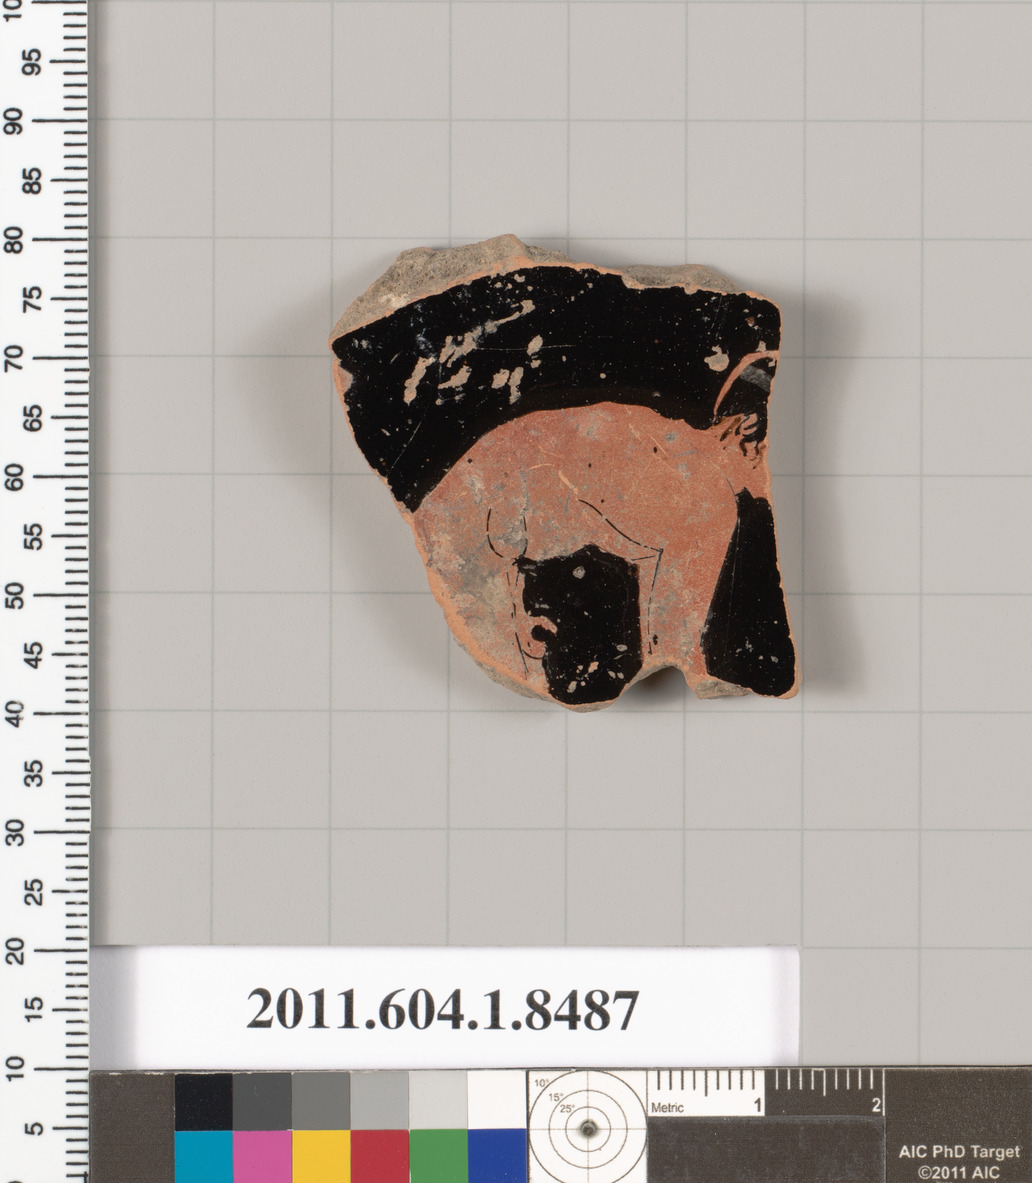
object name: kylix fragment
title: Terracotta fragment of a stemless kylix (drinking cup)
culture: greek, attic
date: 460-450 BCE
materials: terracotta